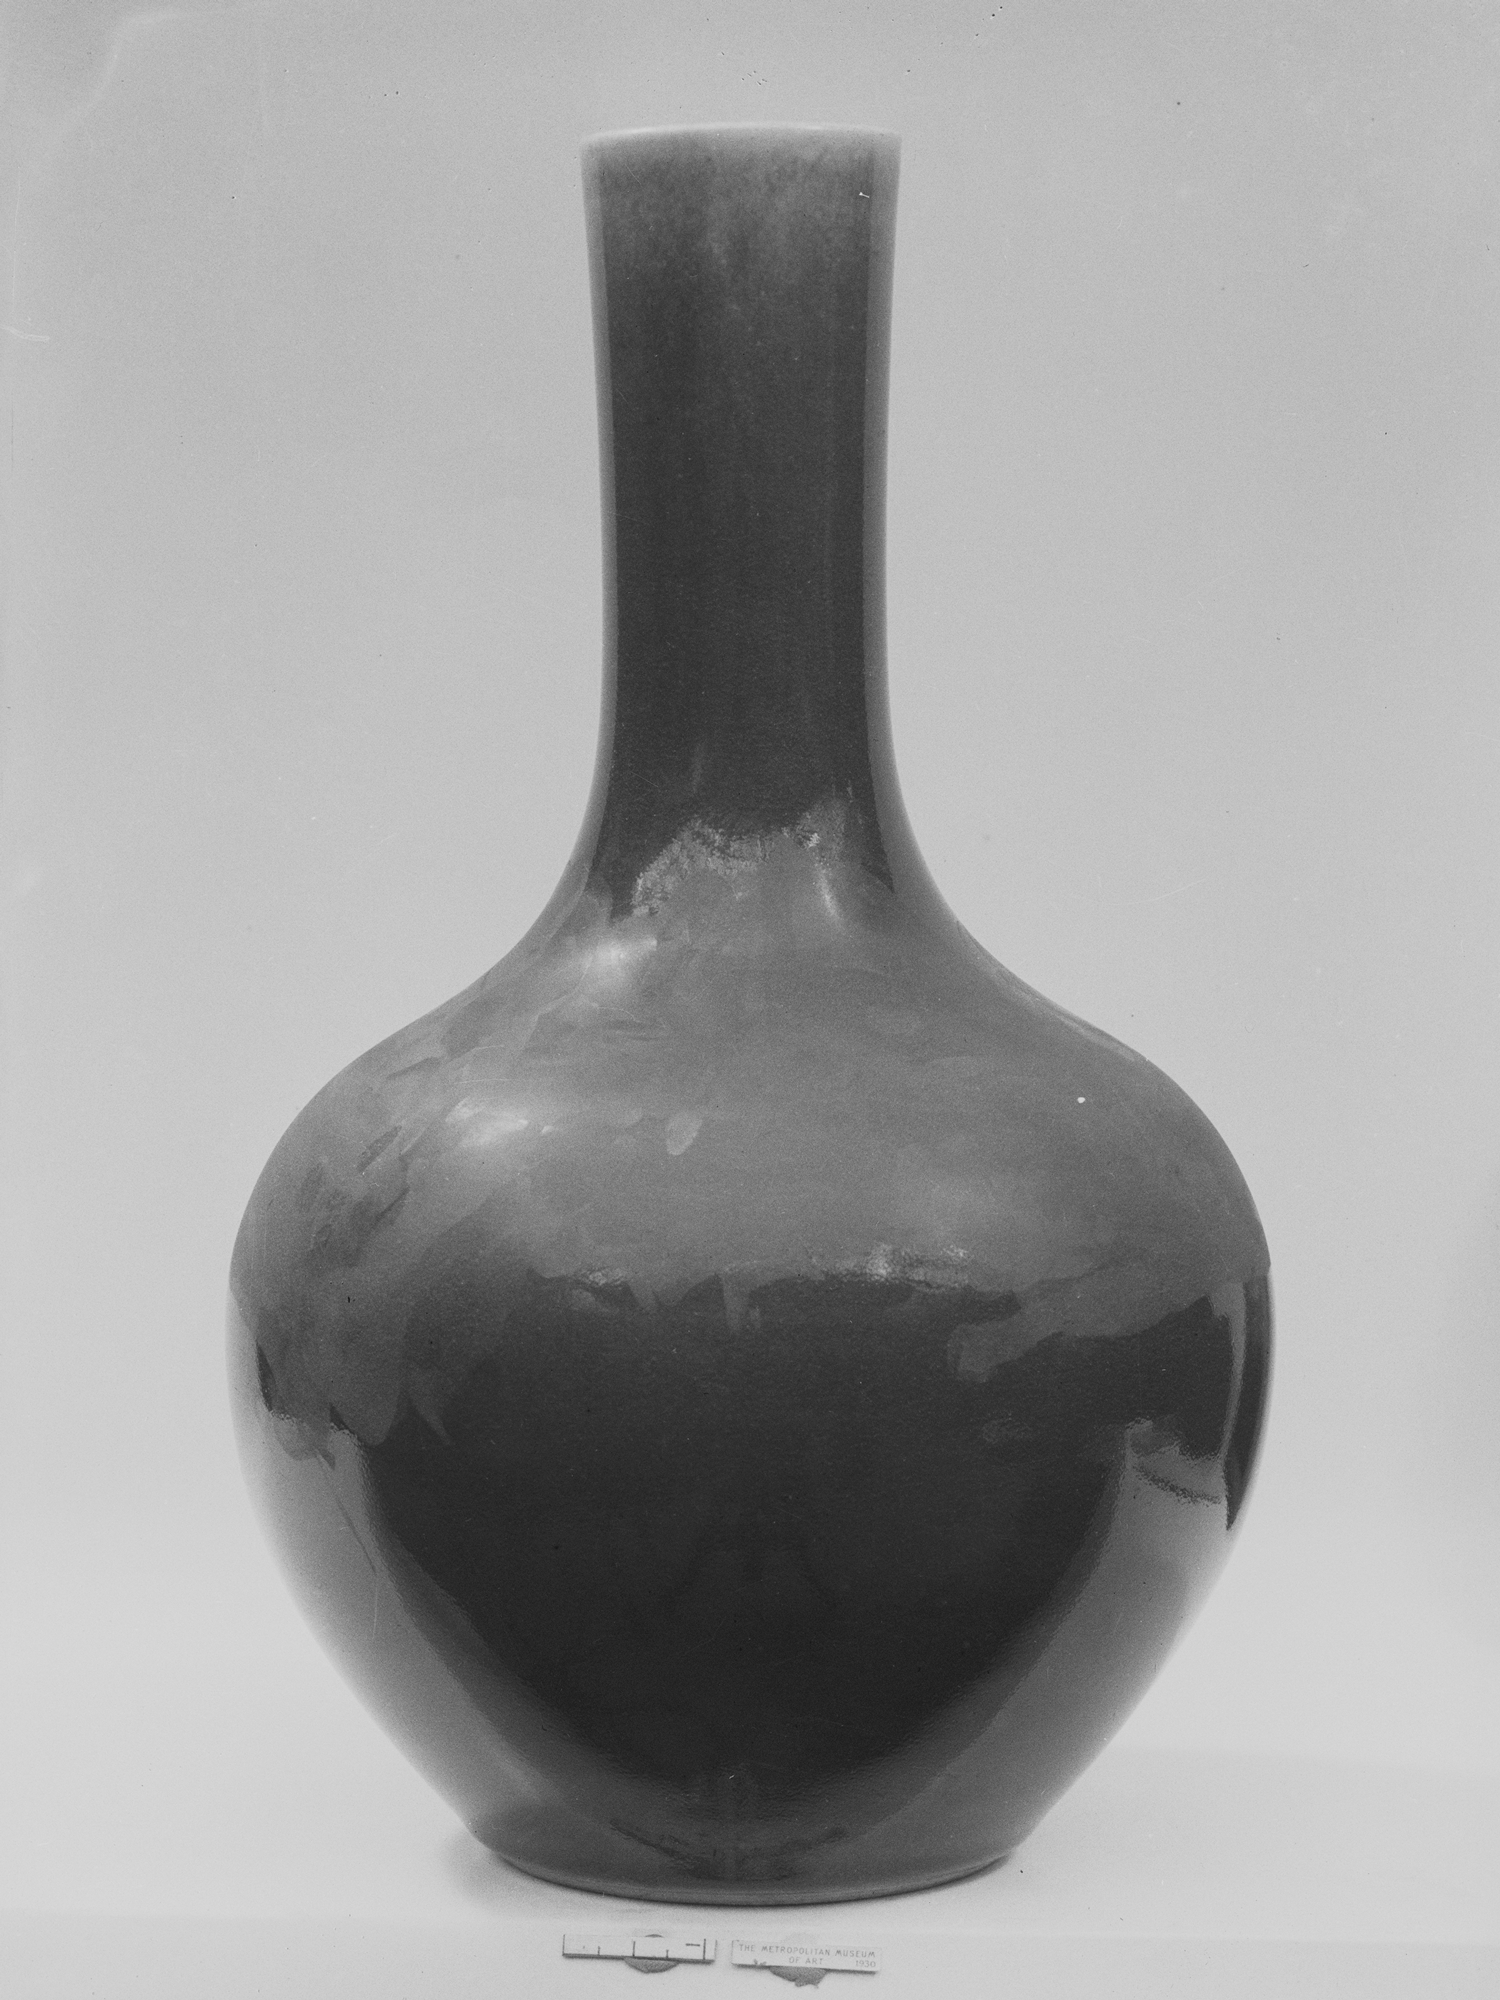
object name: bottle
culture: chinese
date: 1723-1735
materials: glaze, porcelain